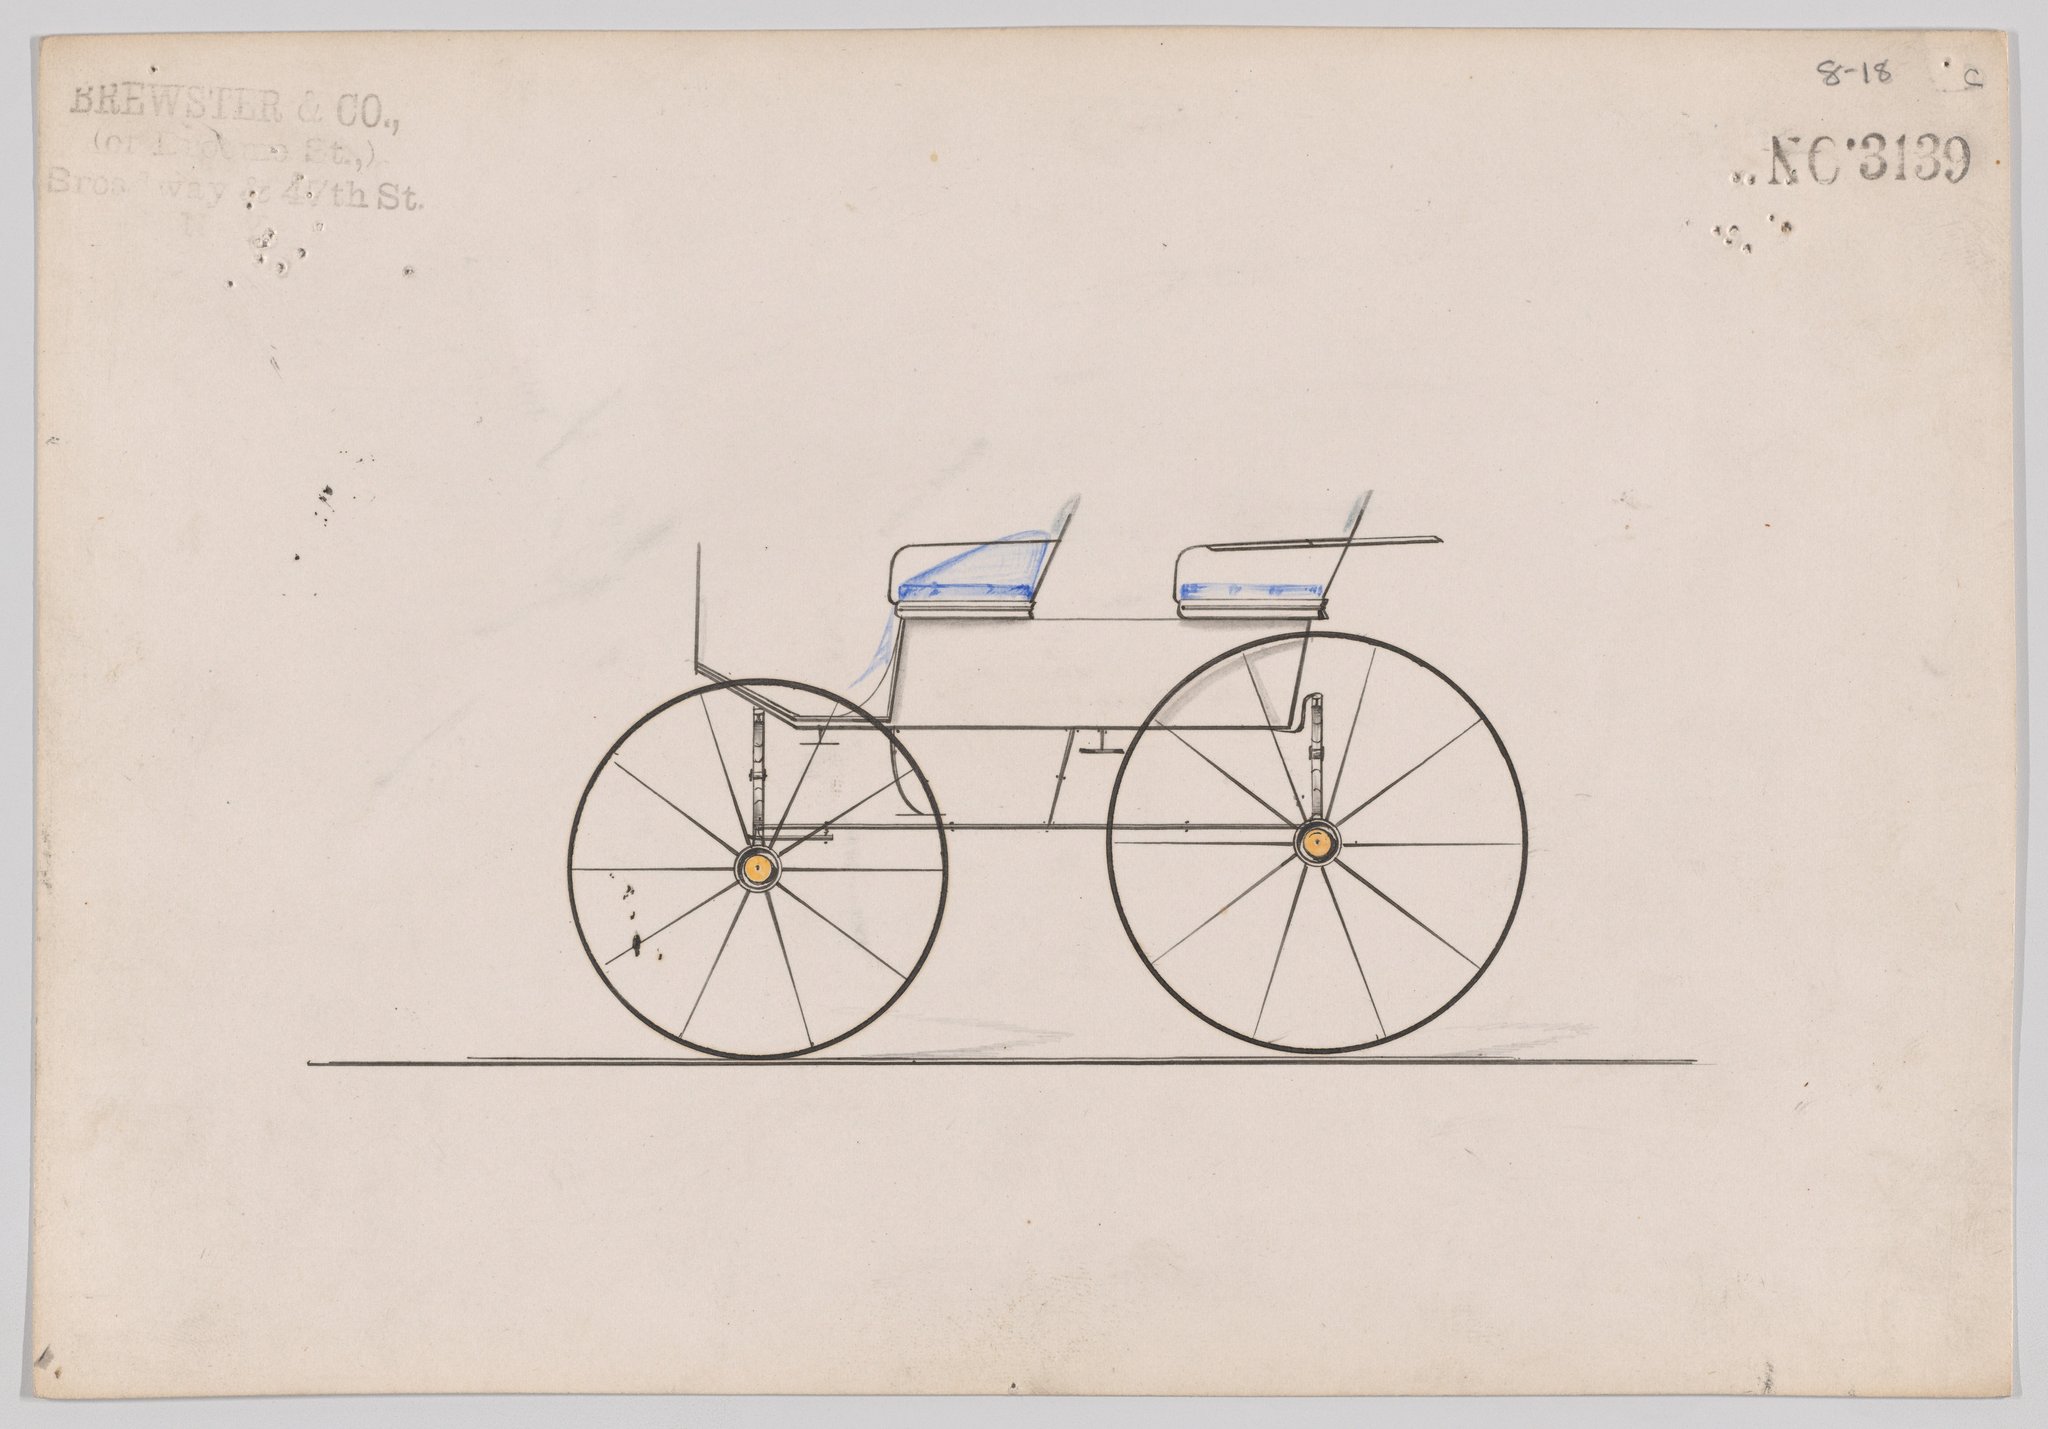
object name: drawing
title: Design for 4 seat Phaeton, no top, no. 3139c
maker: brewster & co.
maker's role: manufacturer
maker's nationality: american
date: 1875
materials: gouache, ink, watercolor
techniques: pen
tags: carriages